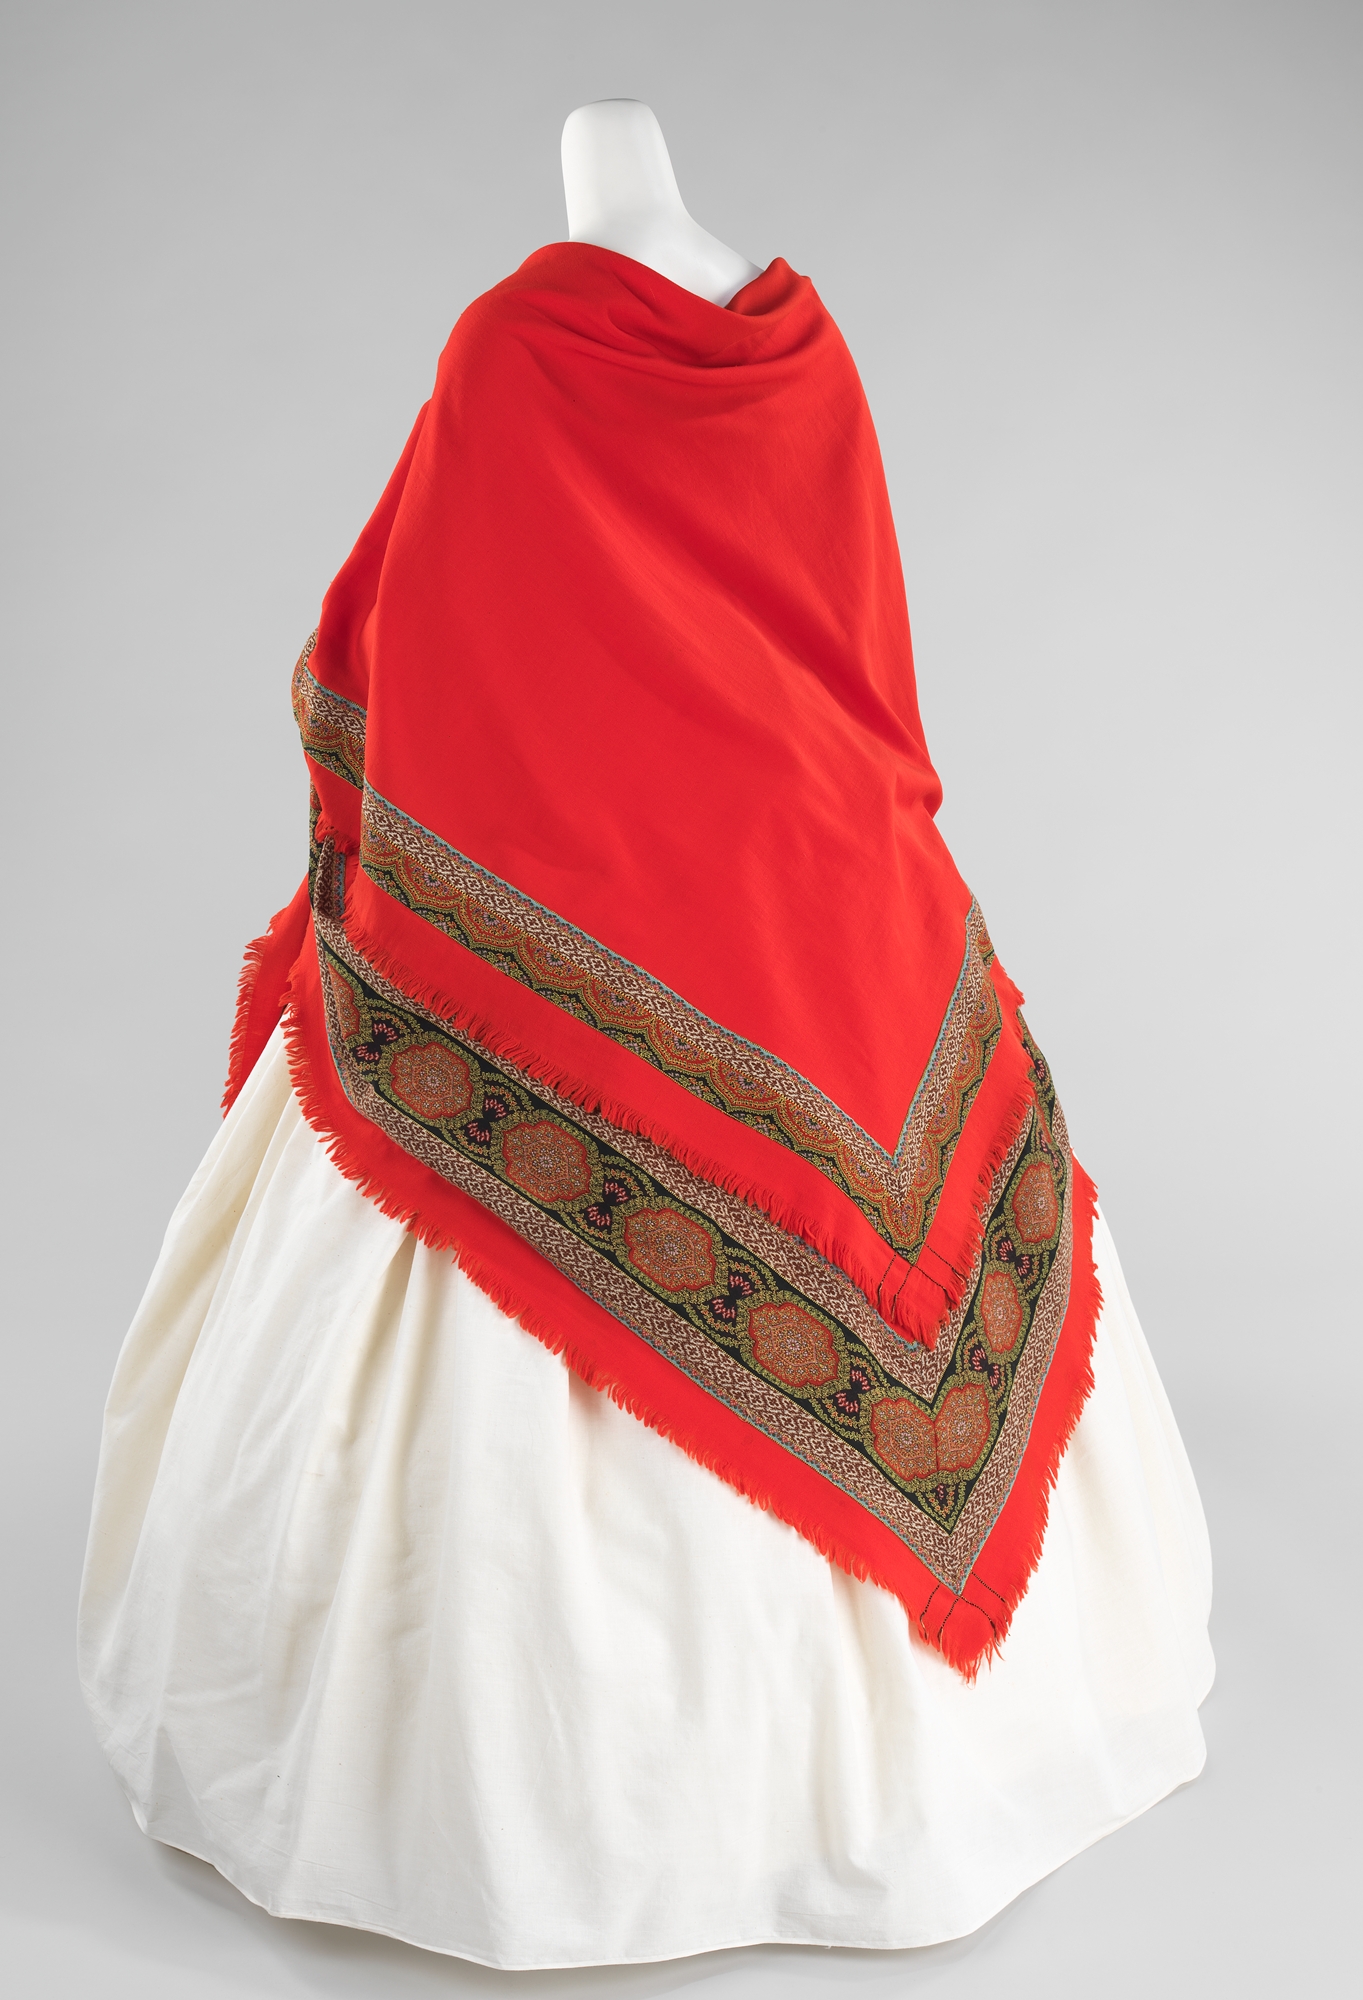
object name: wedding shawl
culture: american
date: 1866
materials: wool